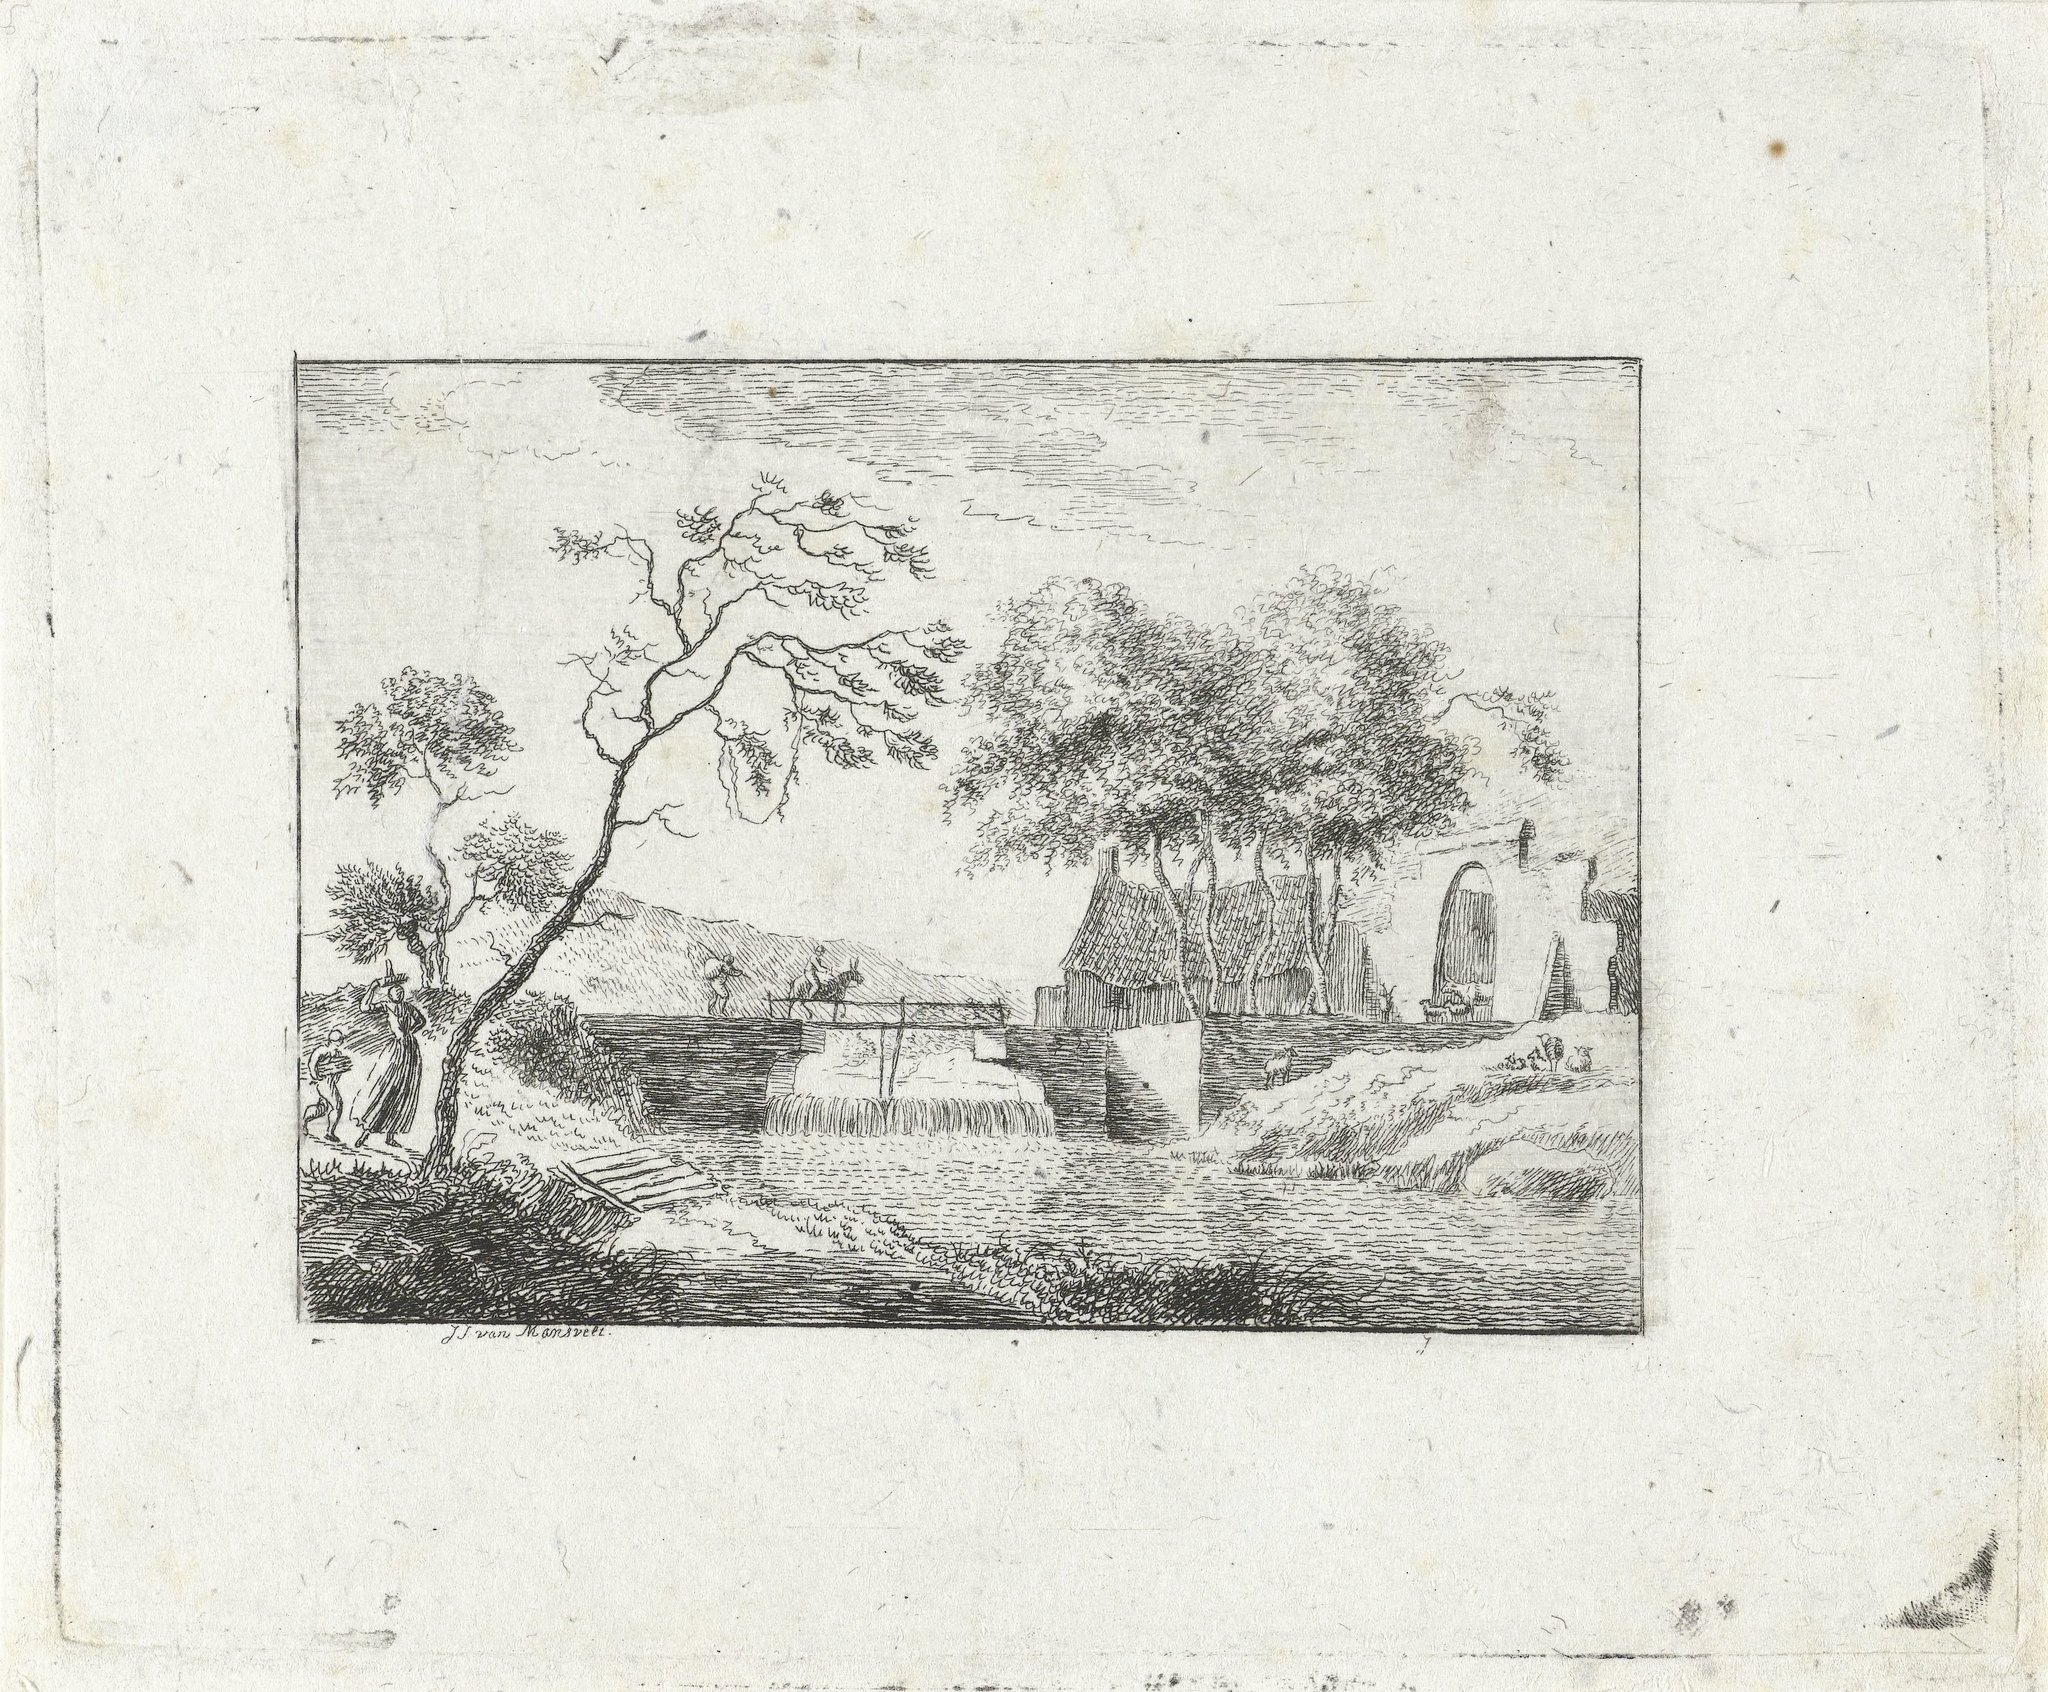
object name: print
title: Landschap met brug en boerderij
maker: jan izaak van mansvelt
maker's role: print maker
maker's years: 1761-1802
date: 1771-1802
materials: paper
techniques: etching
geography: netherlands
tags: landscape with bridge, viaduct or aqueduct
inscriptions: collector's mark: Lugt 2228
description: Een landschap met rechts een boerderij met een poort. Twee figuren, waarvan een op een ezel, steken een rivier over via een houten brug. Links op de voorgrond een vrouw en een jongen.